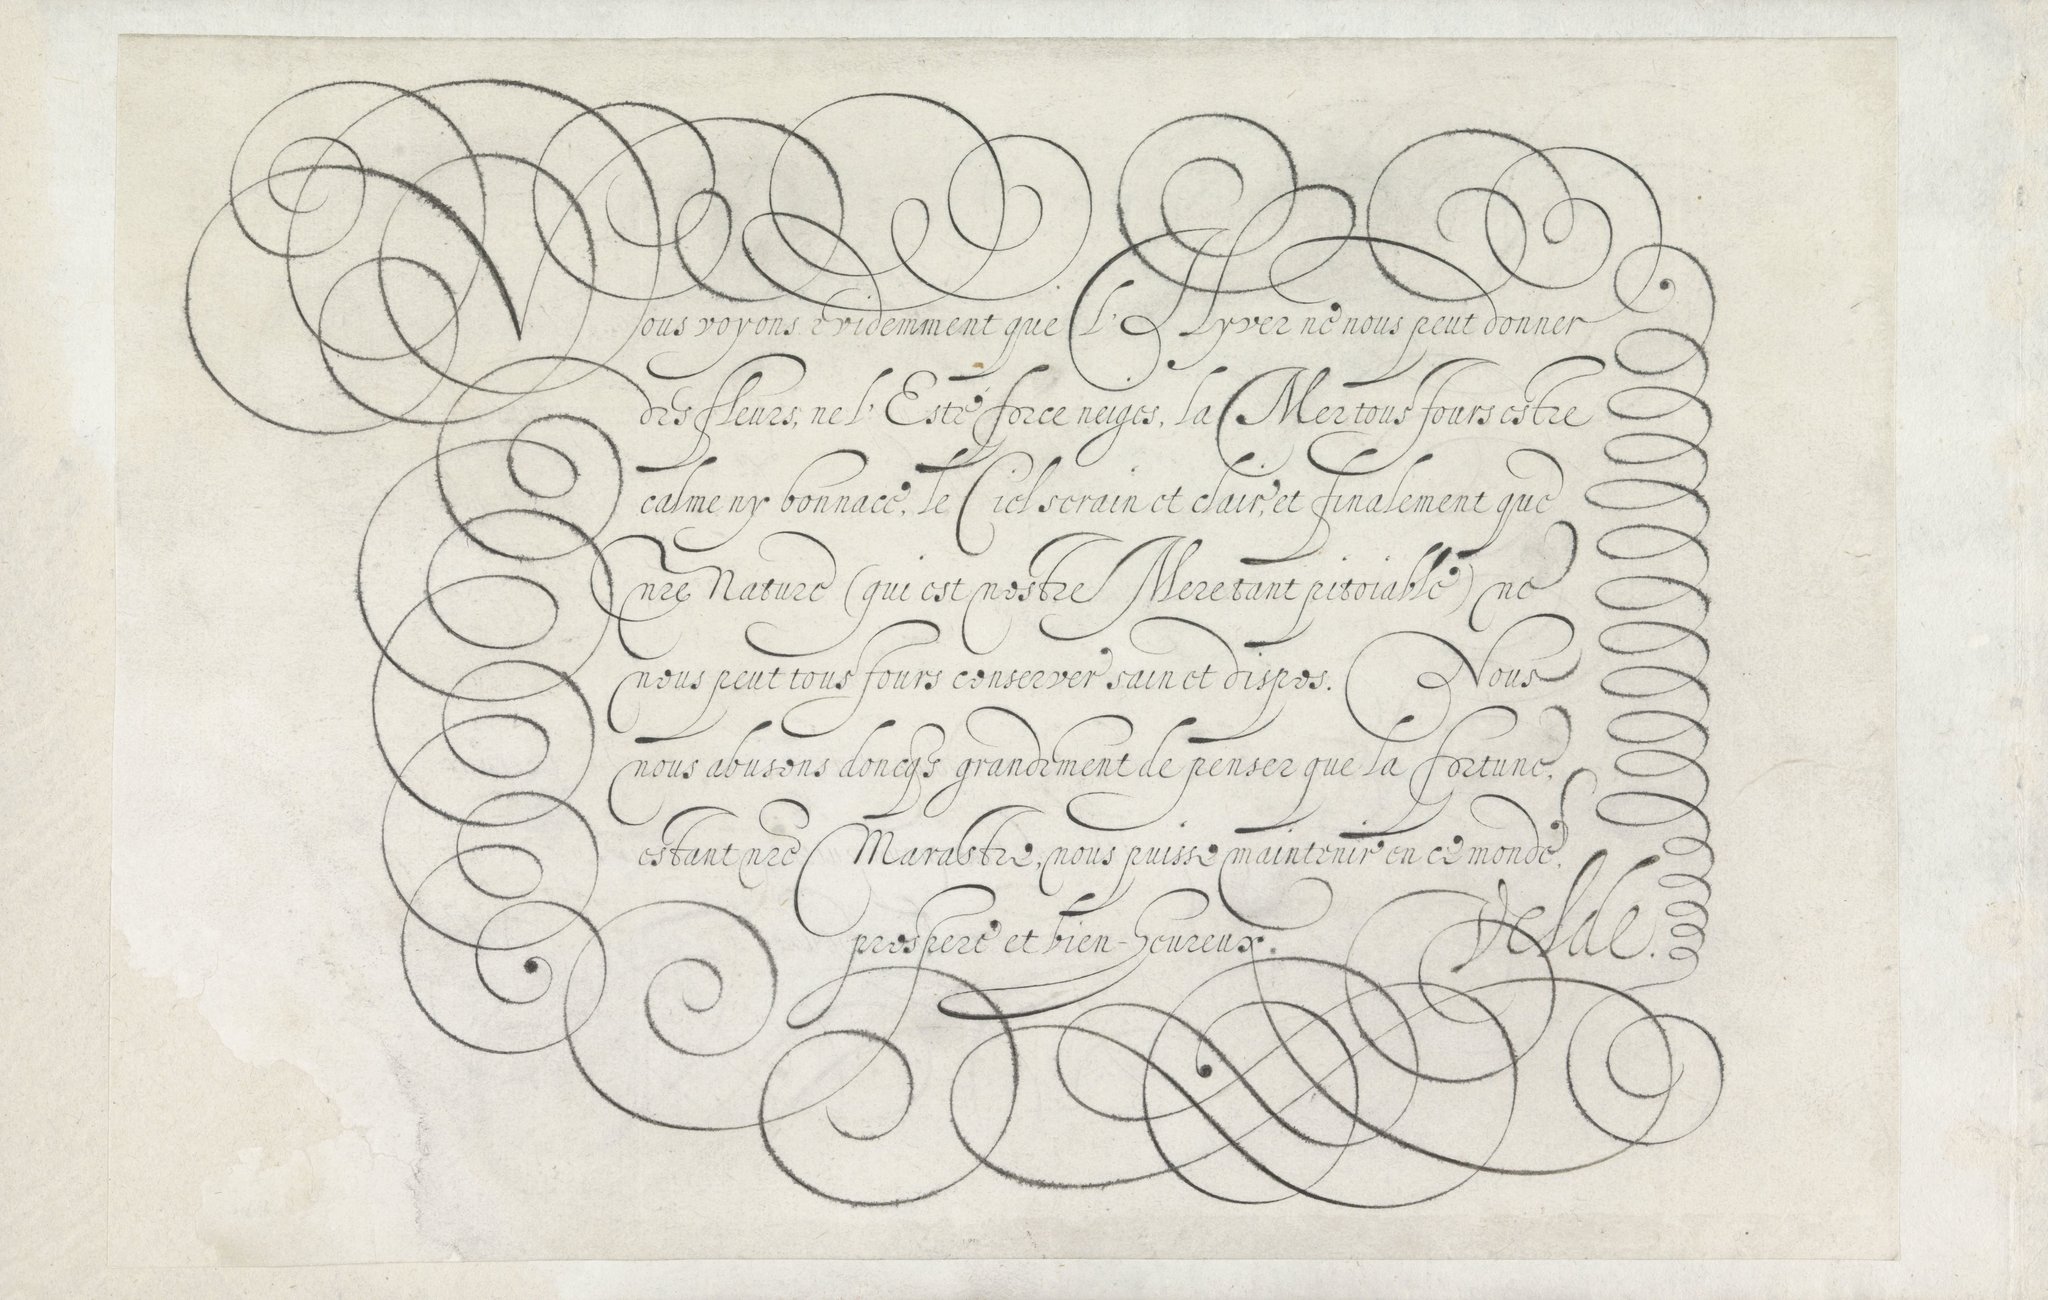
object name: drawing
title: Ontwerp van een schrijfvoorbeeld: Nous voyons evidemment (...)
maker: jan van de velde (i)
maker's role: painter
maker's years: 1568-1623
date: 1605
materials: ink, paper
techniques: calligraphy, pen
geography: rotterdam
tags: calligraphy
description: Kalligrafische tekening met acht regels tekst in het Frans: Nous voyons evidemment ... De tekst is omlijst met krulwerk. De tekening maakt deel uit van een album.